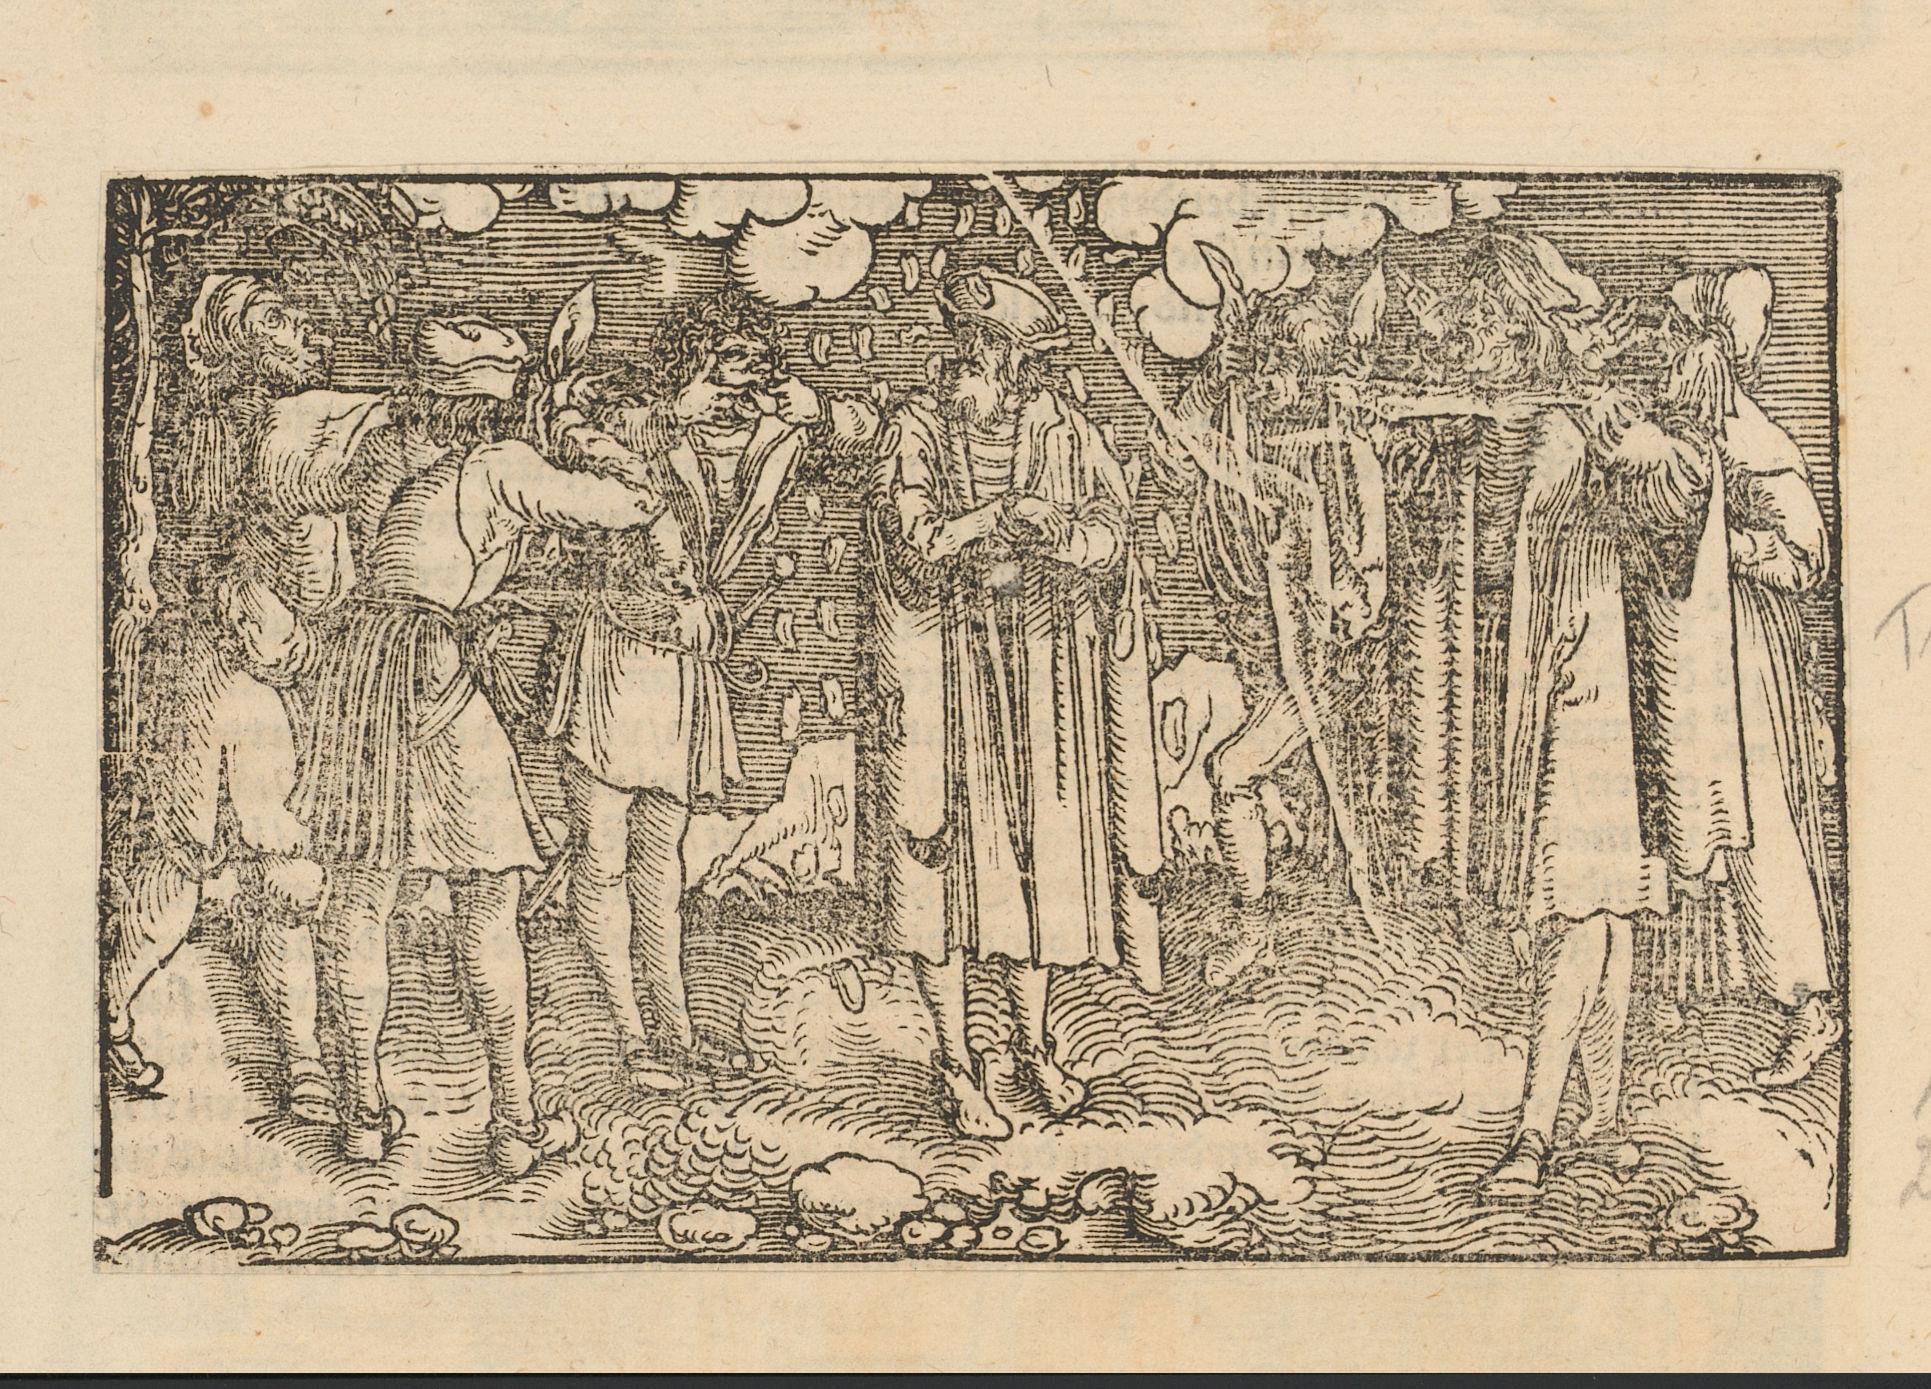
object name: book illustration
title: Mannen drijven spot met de man in het midden terwijl het tongen regent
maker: Anonymous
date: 1514-1532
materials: paper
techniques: letterpress printing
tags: mocking, insulting; teasing, tongue stuck out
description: Deze prent is gebruikt in: Petrarca, Francesco. Von der Artzney bayder Glück, des guten und widerwertigen: unnd weß sich ain yeder inn Gelück und Unglück halten sol (...). Augsburg: Heinrich Steiner, 1532. Deze uitgave is ook bekend onder de titel 'Trostspiegel in Glück und Unglück'.